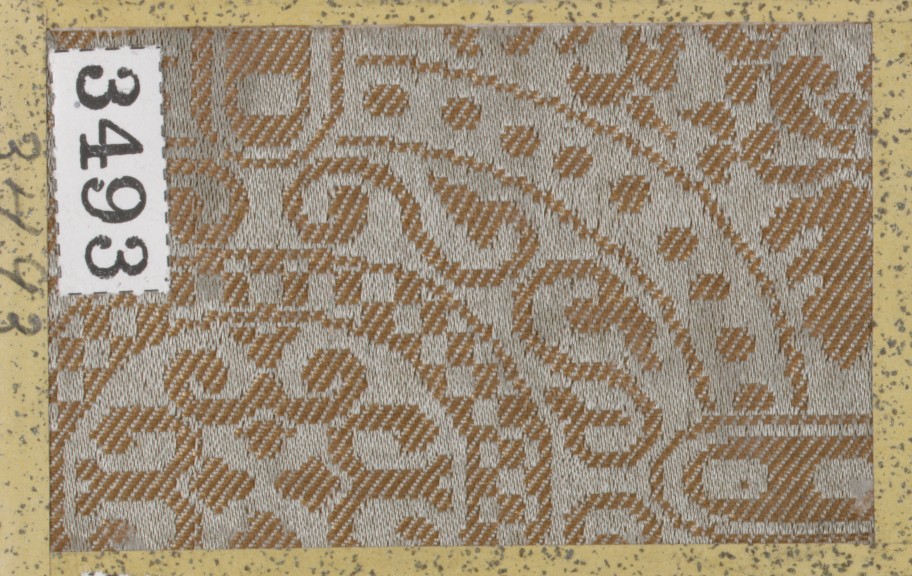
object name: sample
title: Textile Sample from Sample Book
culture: japanese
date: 1801-1900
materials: silk